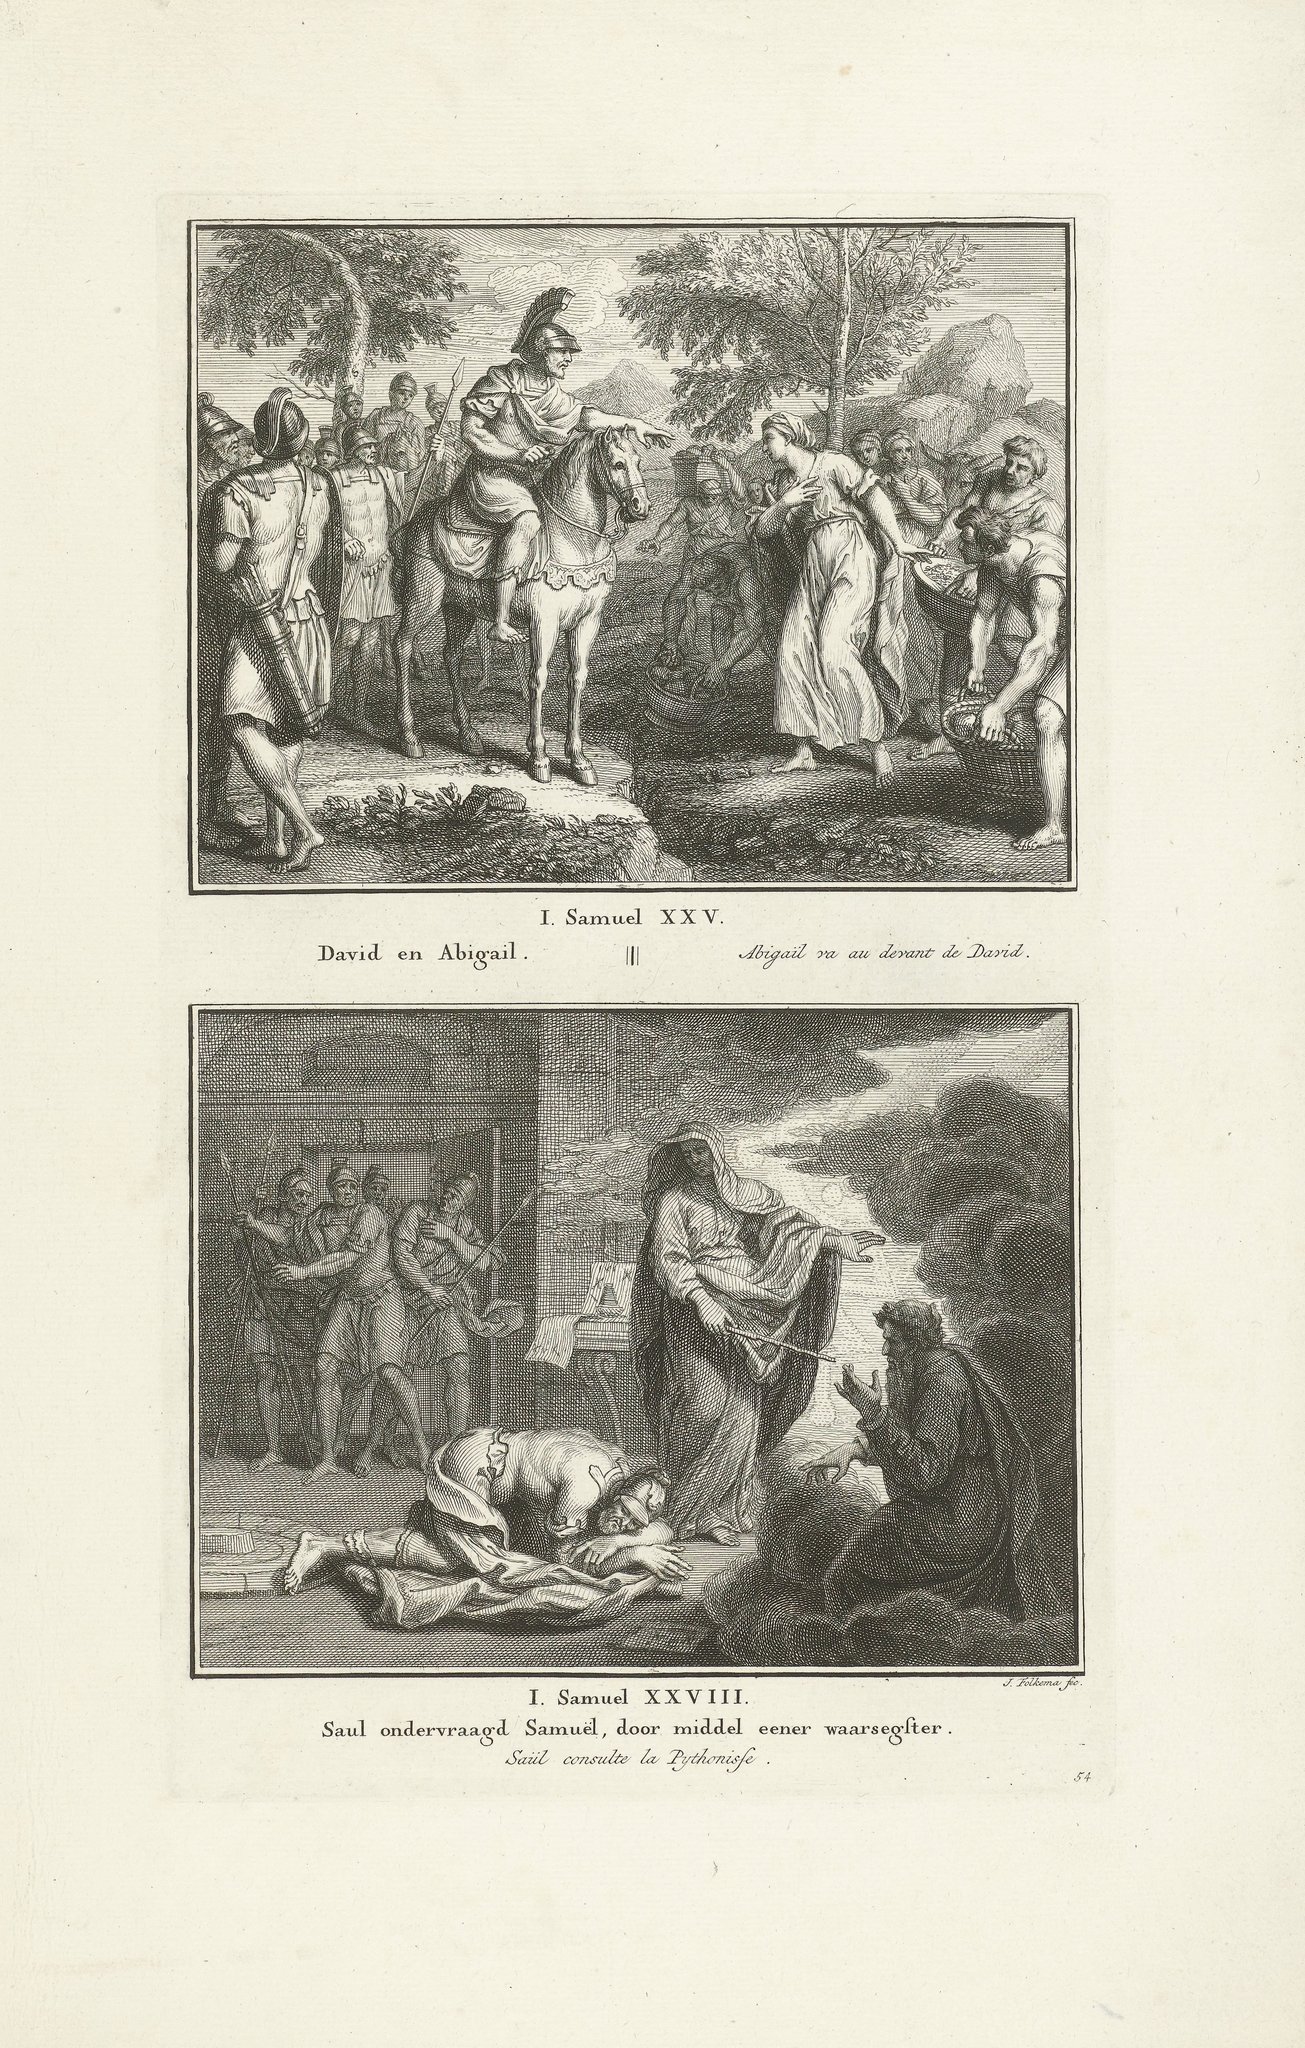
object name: print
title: Ontmoeting van David en Abigaïl, en Saul bij de heks van Endor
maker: jacob folkema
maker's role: draughtsman, print maker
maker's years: 1692-1767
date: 1702-1767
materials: paper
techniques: etching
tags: david and abigail (1 samuel 25), saul and the witch of endor (1 samuel 28:3-25)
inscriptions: collector's mark: Lugt 2233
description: Twee Bijbelse voorstellingen uit 1 Sam. 25 en 1 Sam. 28. Abigaïl ontmoet haar toekomstige echtgenoot David, en Saul spreekt met Samuels geest bij de heks van Endor. Twee voorstellingen van één plaat, elk voorzien van een titel in het Nederlands en Frans. Geheel rechtsonder genummerd: 54.